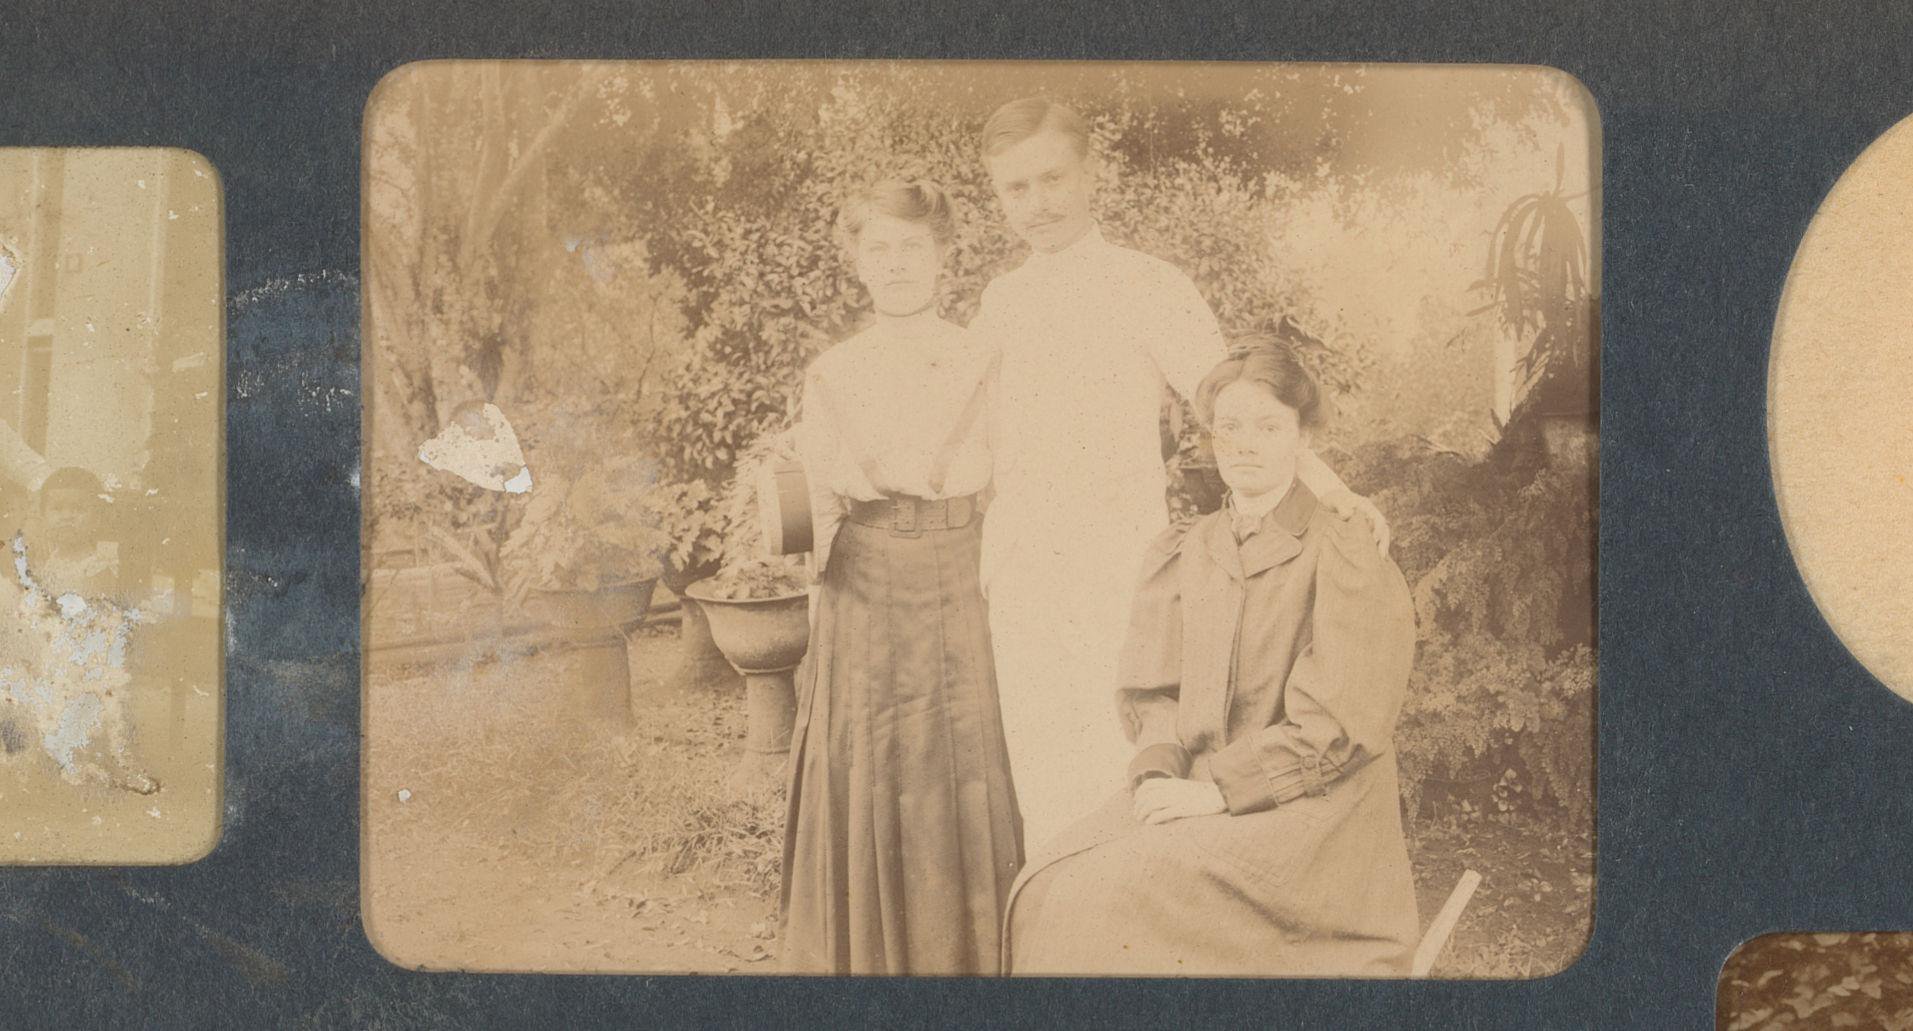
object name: album leaf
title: Groepsportret van Tjuut, Gurit en Jenny Hellendoorn, mogelijk in Indonesië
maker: Anonymous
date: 1911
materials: paper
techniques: gelatin silver print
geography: indonesia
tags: adolescent, young woman, maiden, youth, adolescent, anonymous historical persons portrayed in a group, in a group-portrait, indonesia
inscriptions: inscription: ‘familie Hellendoorn/ Tjuut Gurit Jen 1911.’